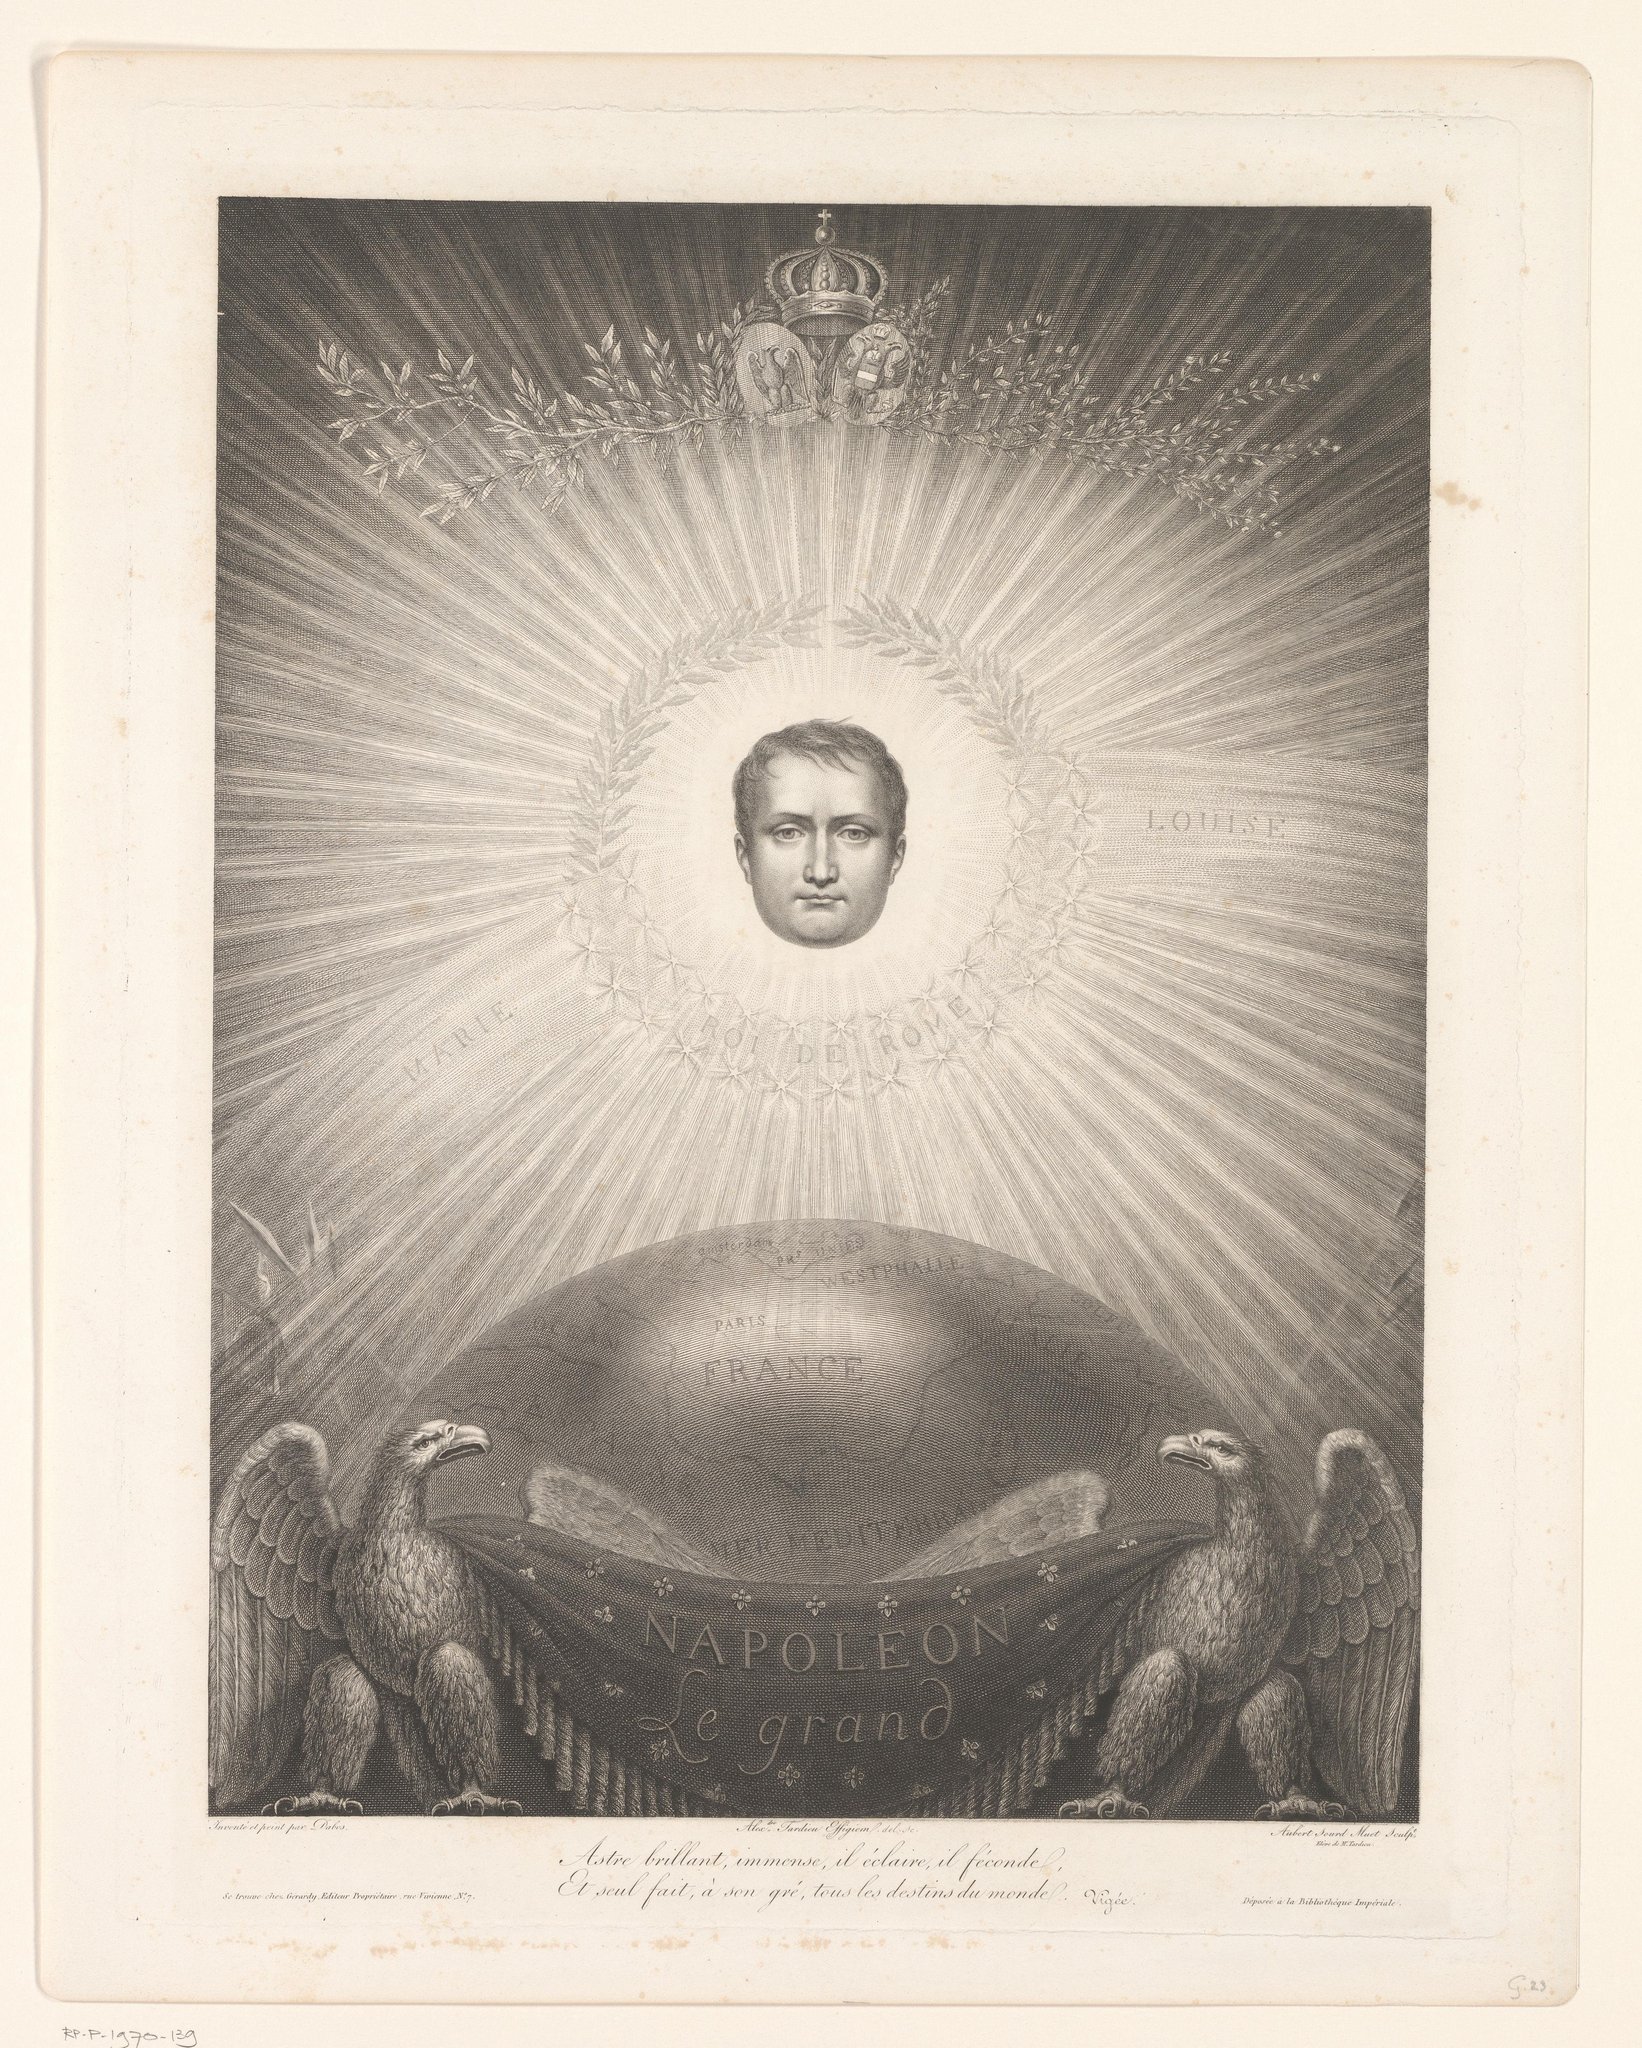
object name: print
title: Verheerlijking van Napoleon Bonaparte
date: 1810-1815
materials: paper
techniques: engraving, etching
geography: paris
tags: napoleon i (emperor of the french), deaf and non-verbal, formerly known as 'deaf-mute', predatory birds: eagle, historical persons, ruler, sovereign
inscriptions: collector's mark: Lugt 2228a, : ‘Déposé à la Bibliothèque Impériale’, collector's mark: Lugt 2760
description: Hoofd van Napoleon in een lauerkrans boven een wereldbol.